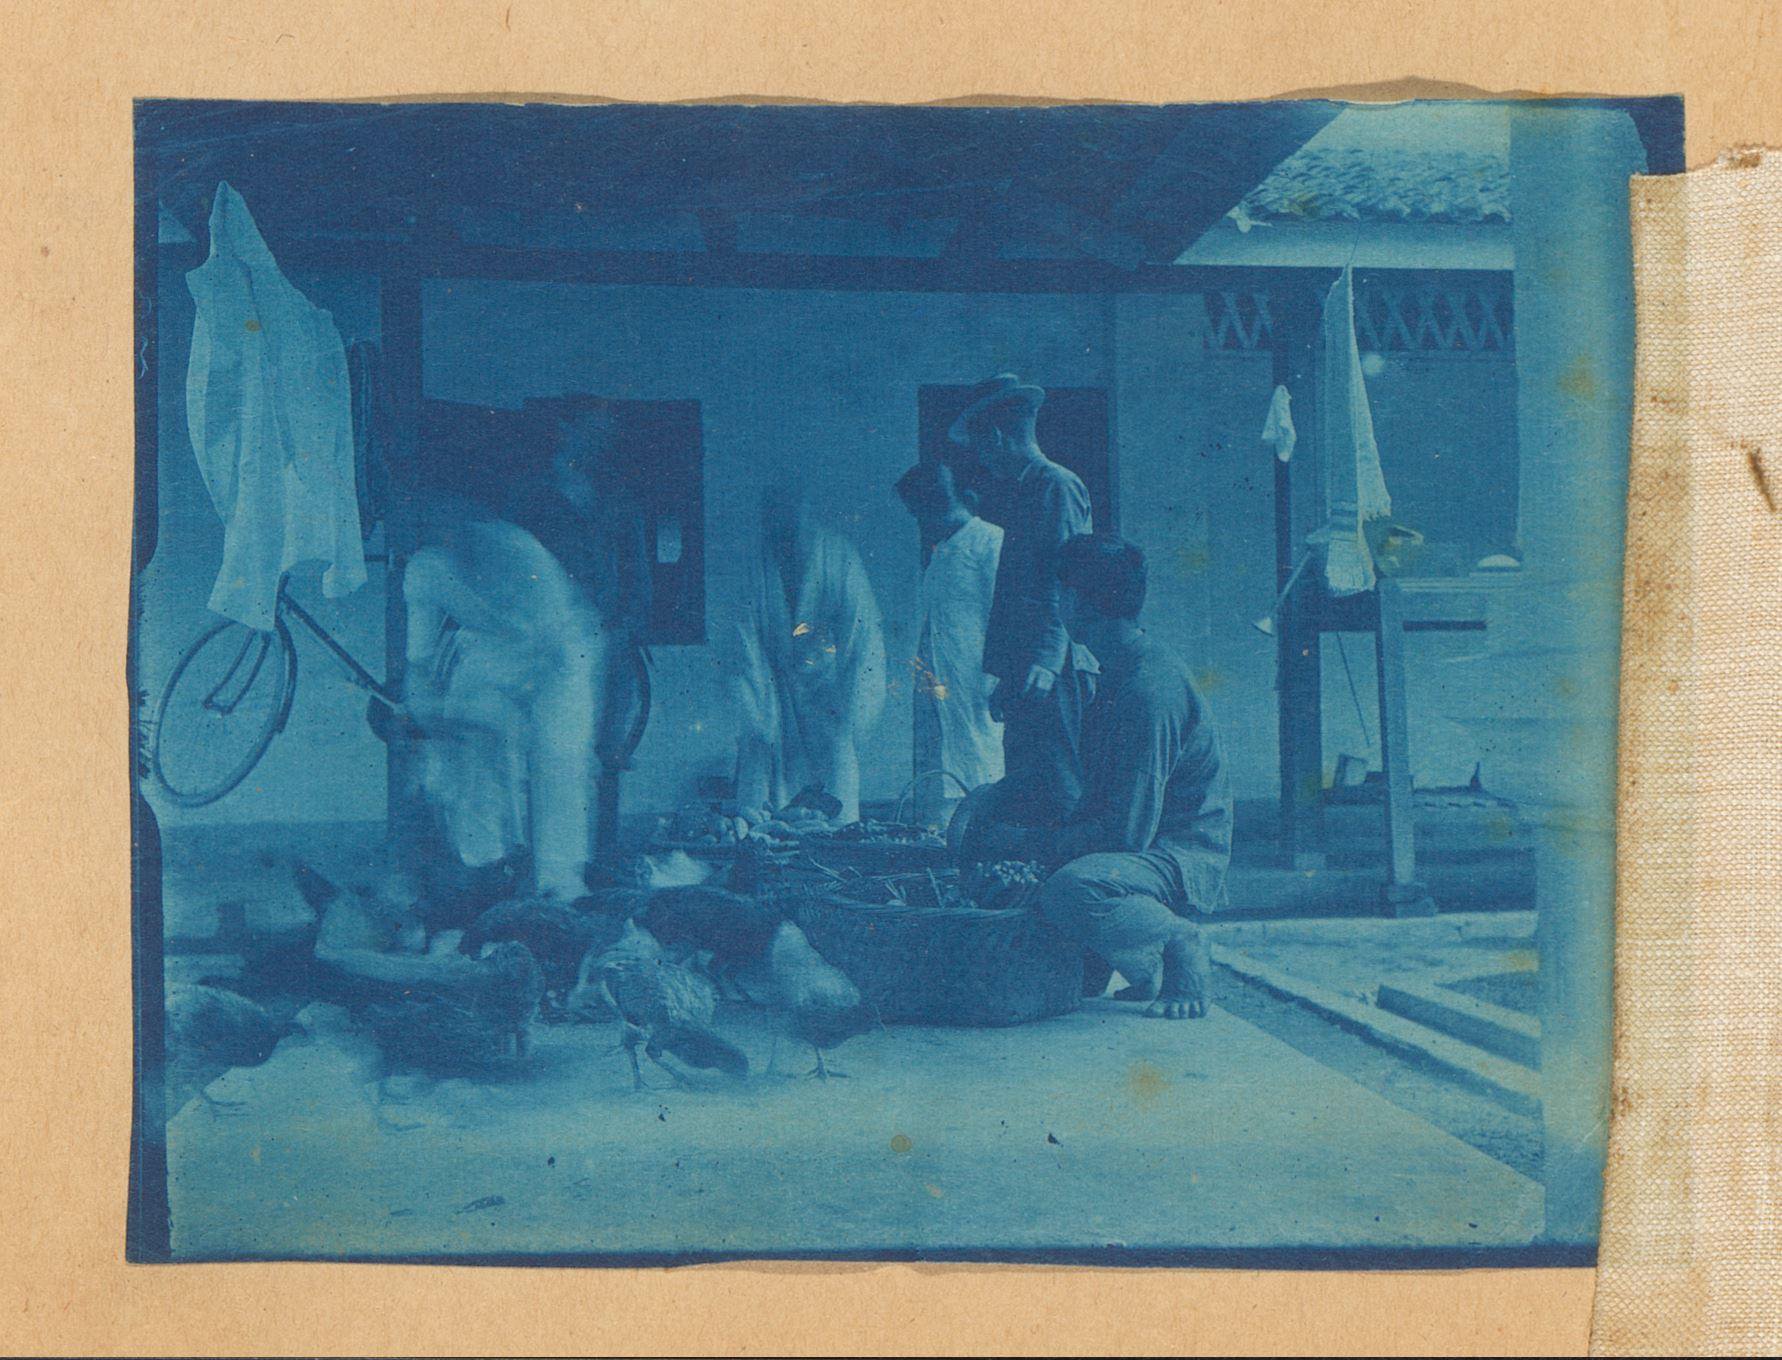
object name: photograph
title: Verkopers op een veranda in Nederlands-Indië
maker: Anonymous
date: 1917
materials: photographic support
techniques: cyanotype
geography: dutch east indies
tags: wandering or travelling merchant, fowl (cock, hen, chicken, etc.), loggia, verandah, porch, dutch east indies, the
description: Onderdeel van Familiealbum met foto's van een familie in de voormalige kolonie Nederlands-Indië en van een suikerfabriek in Purworejo.